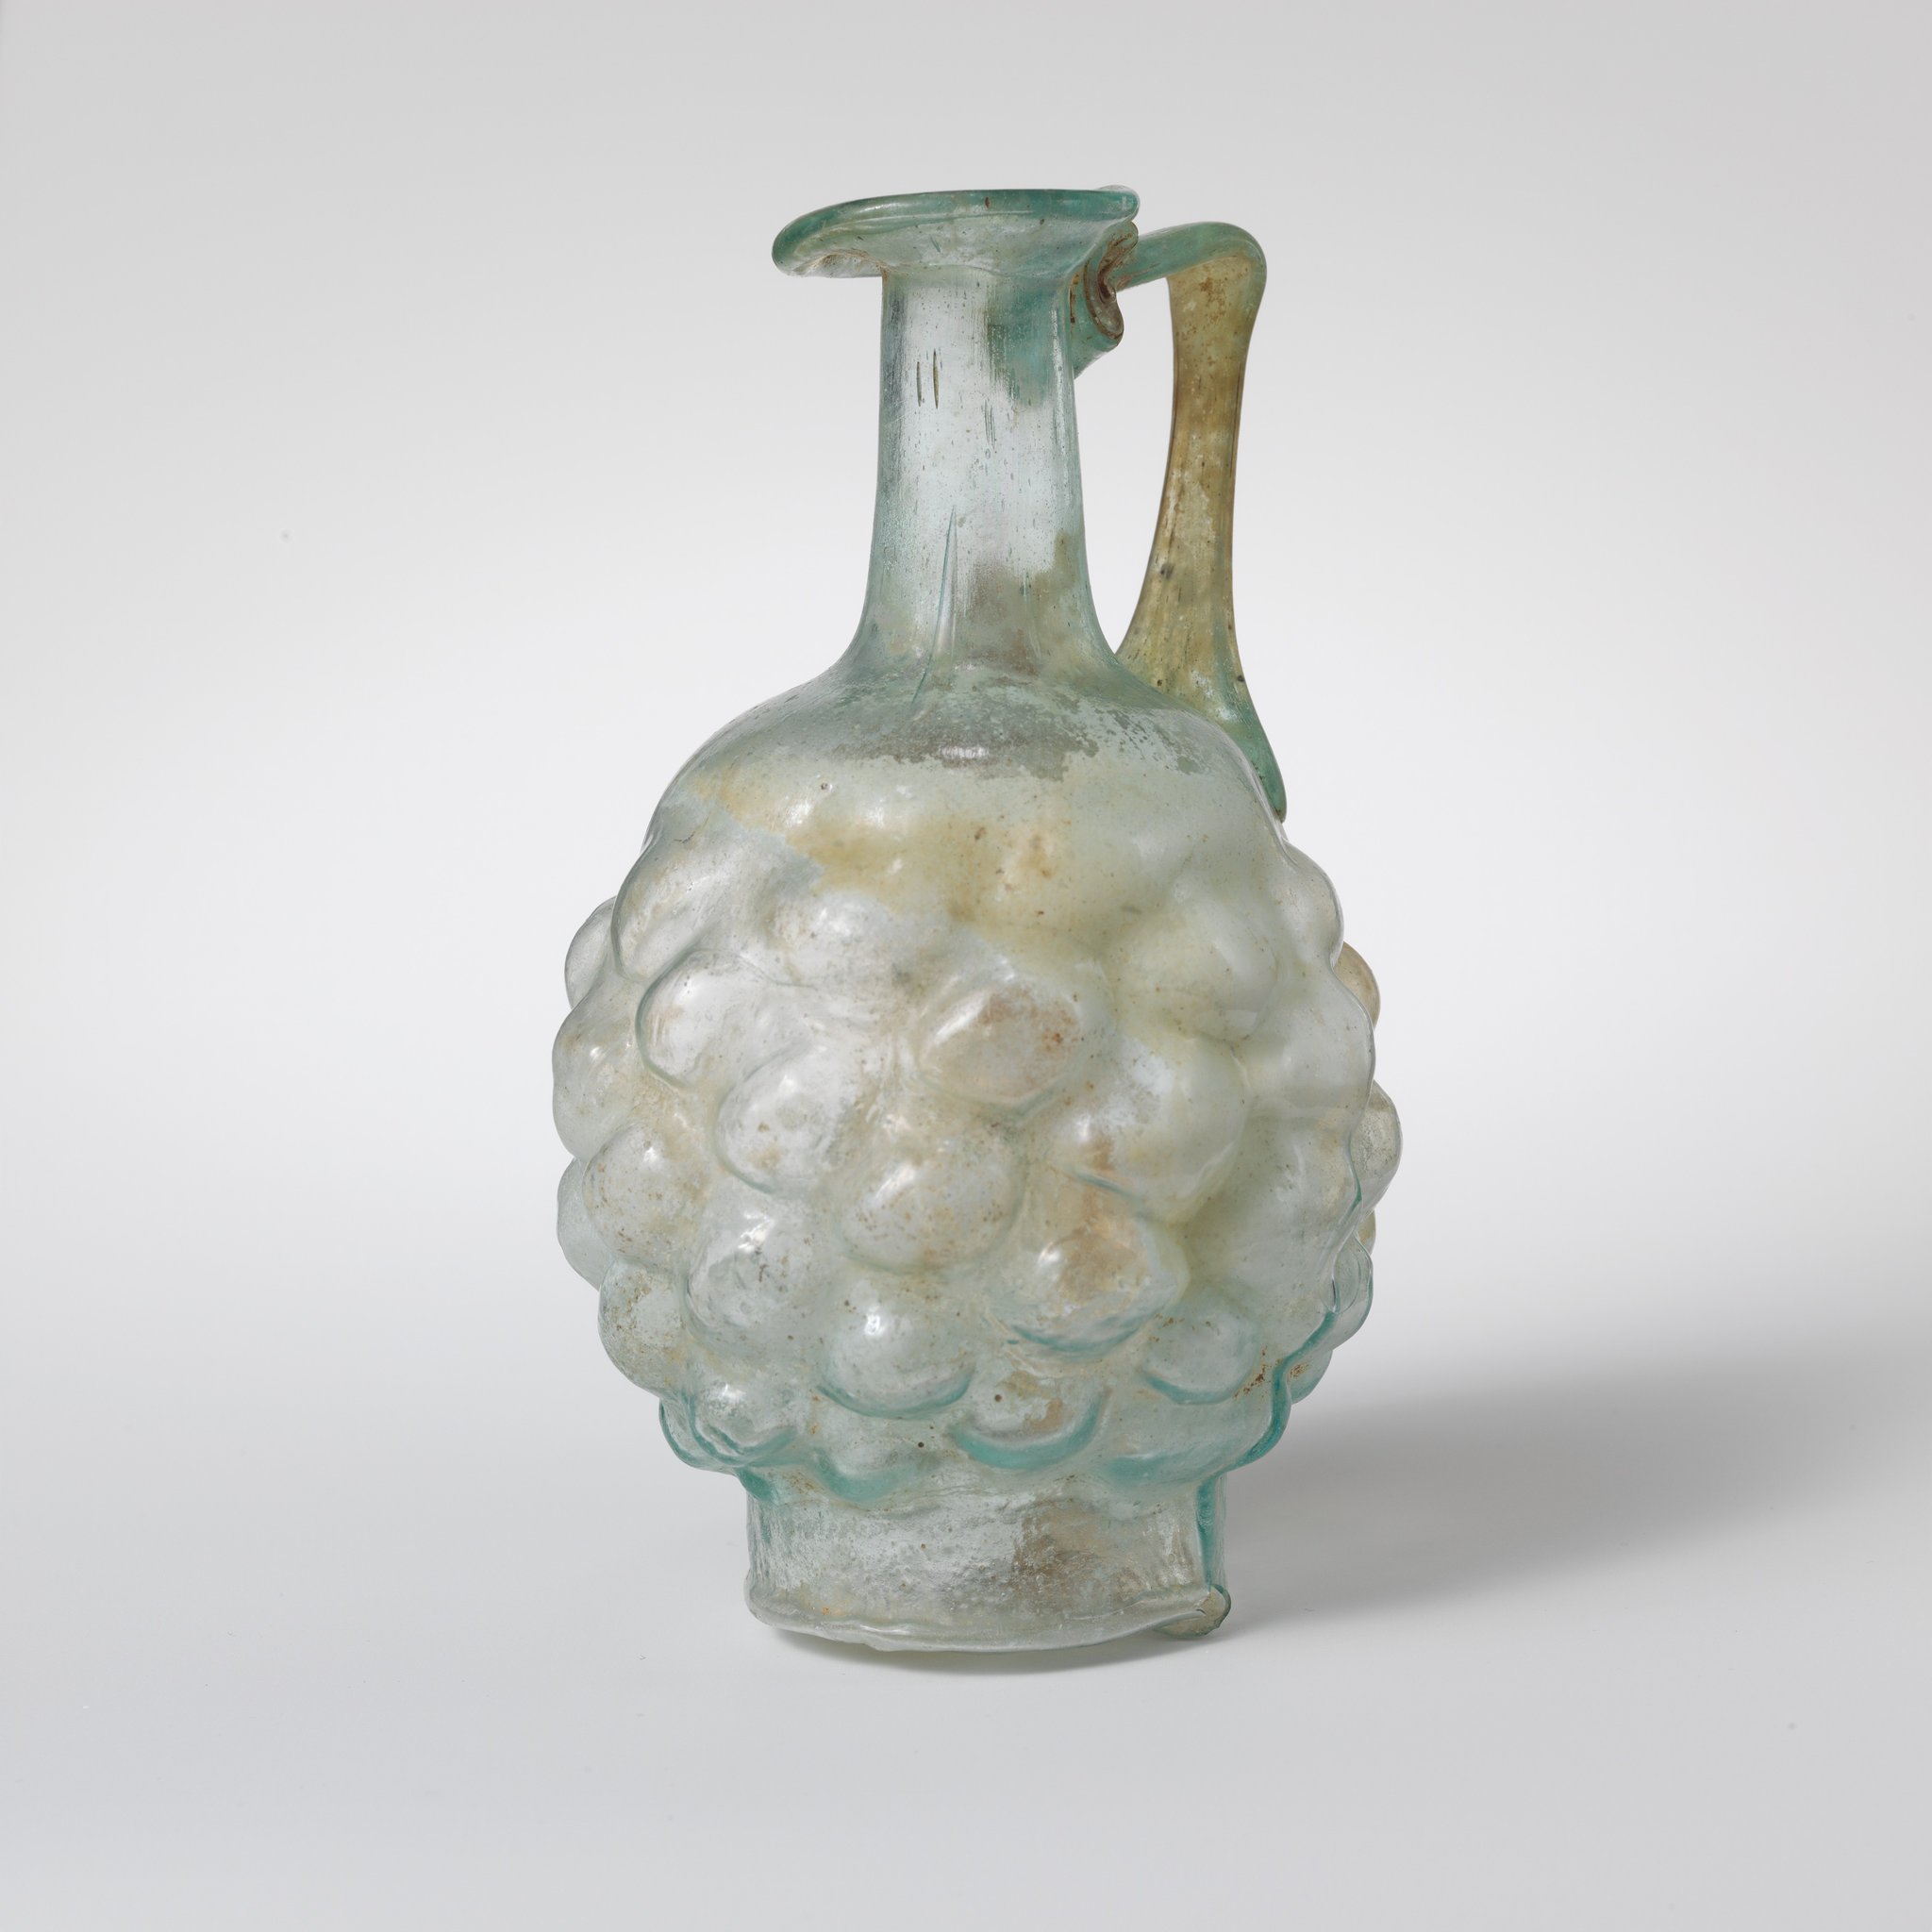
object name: flask in the form of a pine cone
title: Glass jug in the form of a pine cone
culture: roman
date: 51-100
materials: glass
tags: pinecones